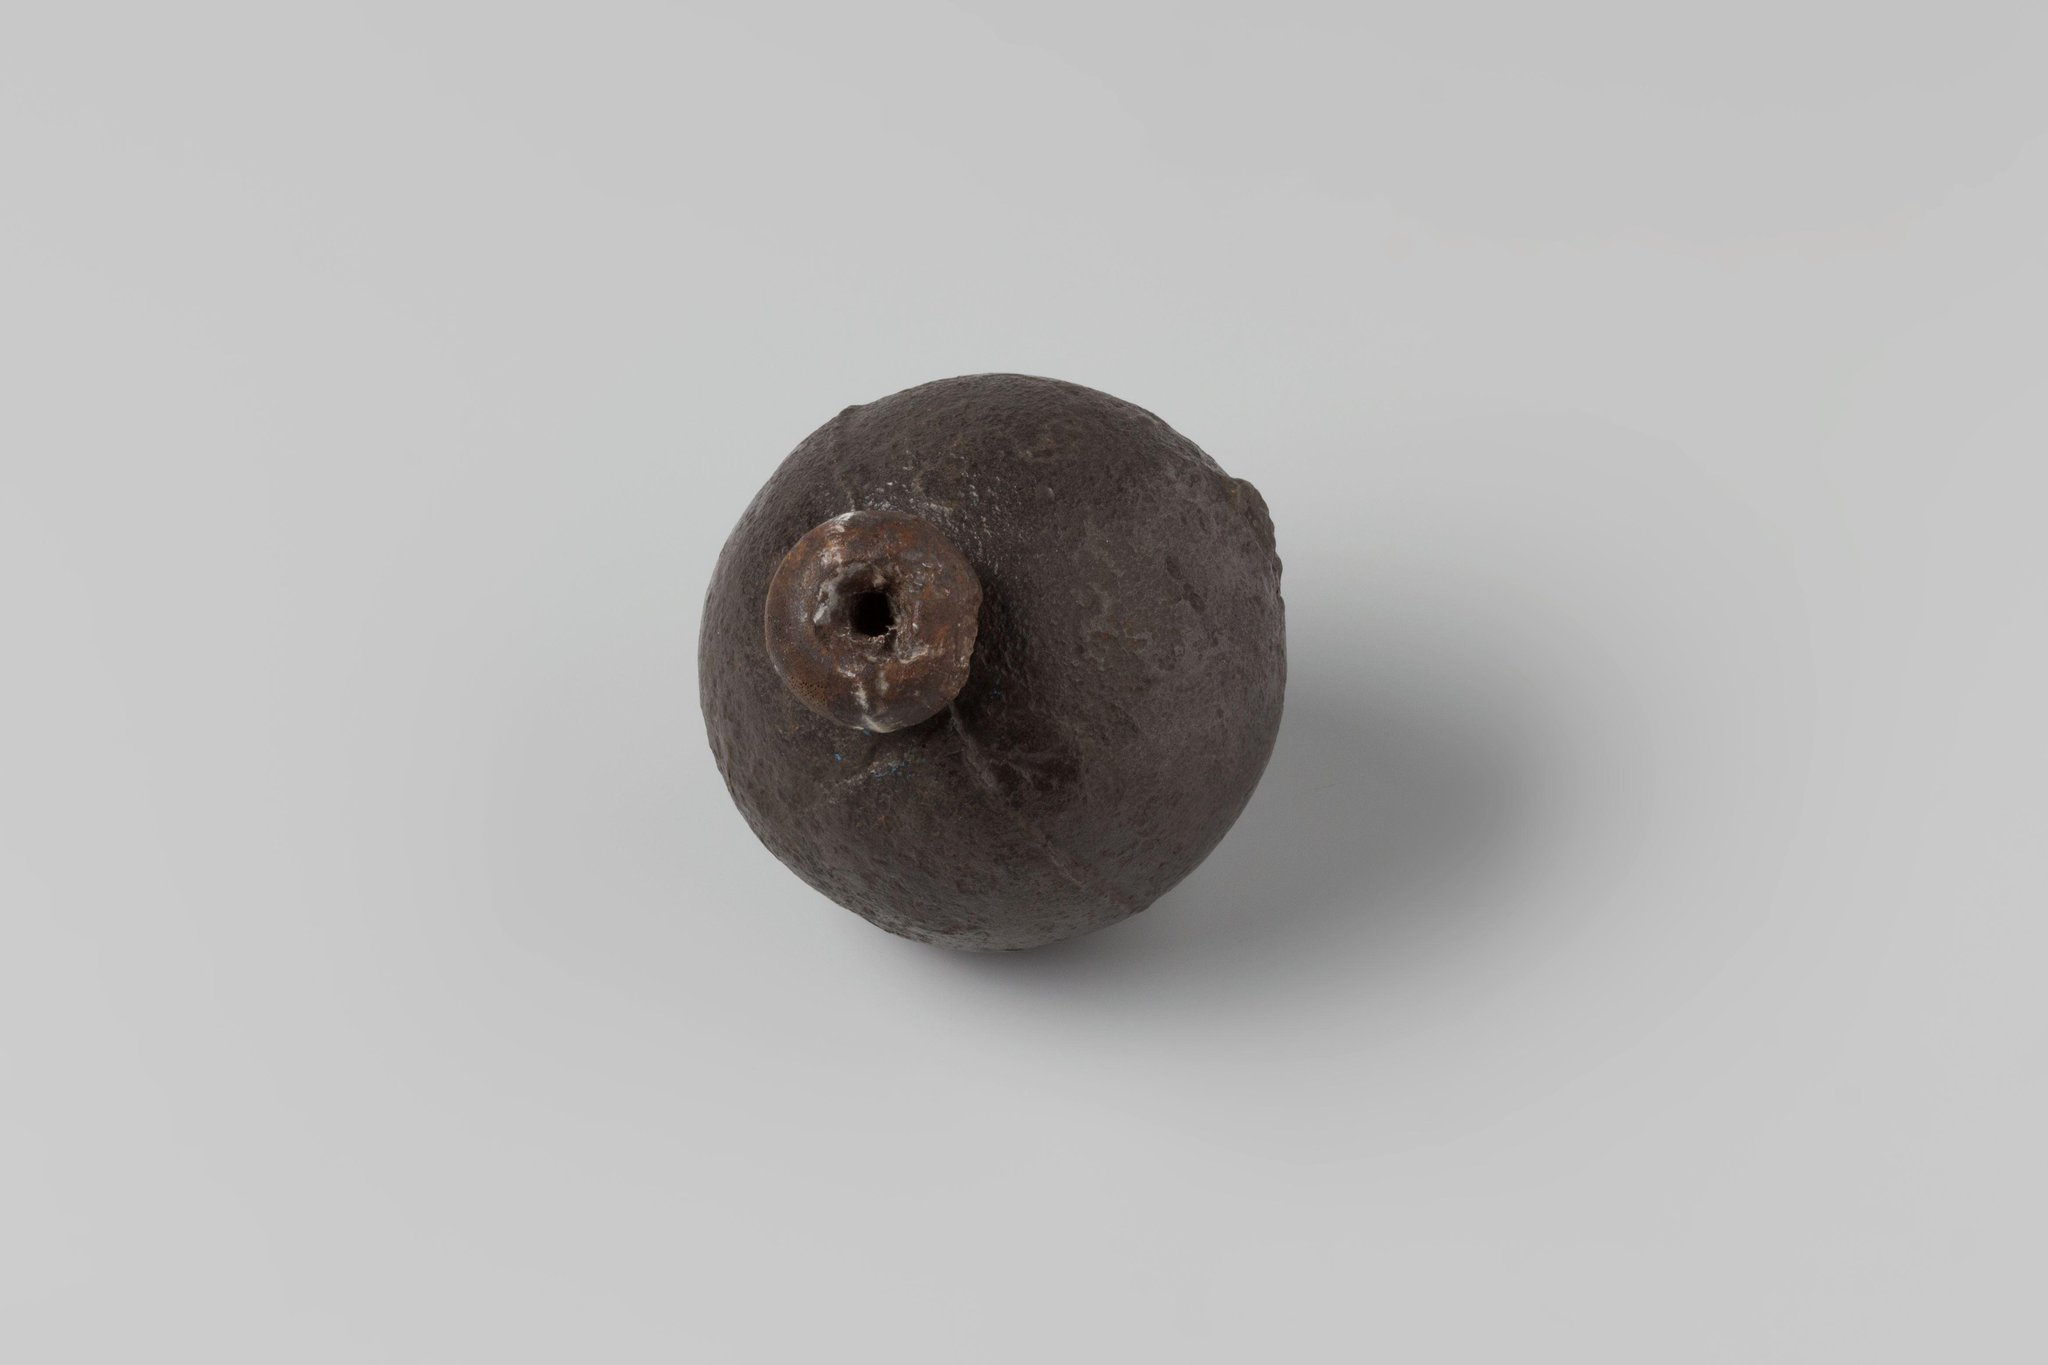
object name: hand grenade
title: Handgranaat uit het wrak van de Oost-Indiëvaarder Princesse Maria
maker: Anonymous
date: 1682-1686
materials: iron, fiber, wood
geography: middelburg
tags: princesse maria (schip), verenigde oostindische compagnie, scilly-eilanden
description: Gietijzeren handgranaat, ronde holle bol die gevuld was met kruit en een ronde opening waarin een buis was gekit met ontvlambaar materiaal. De granaat was in touw gebonden om de buis op zijn plaats te houden. Handgrenade.